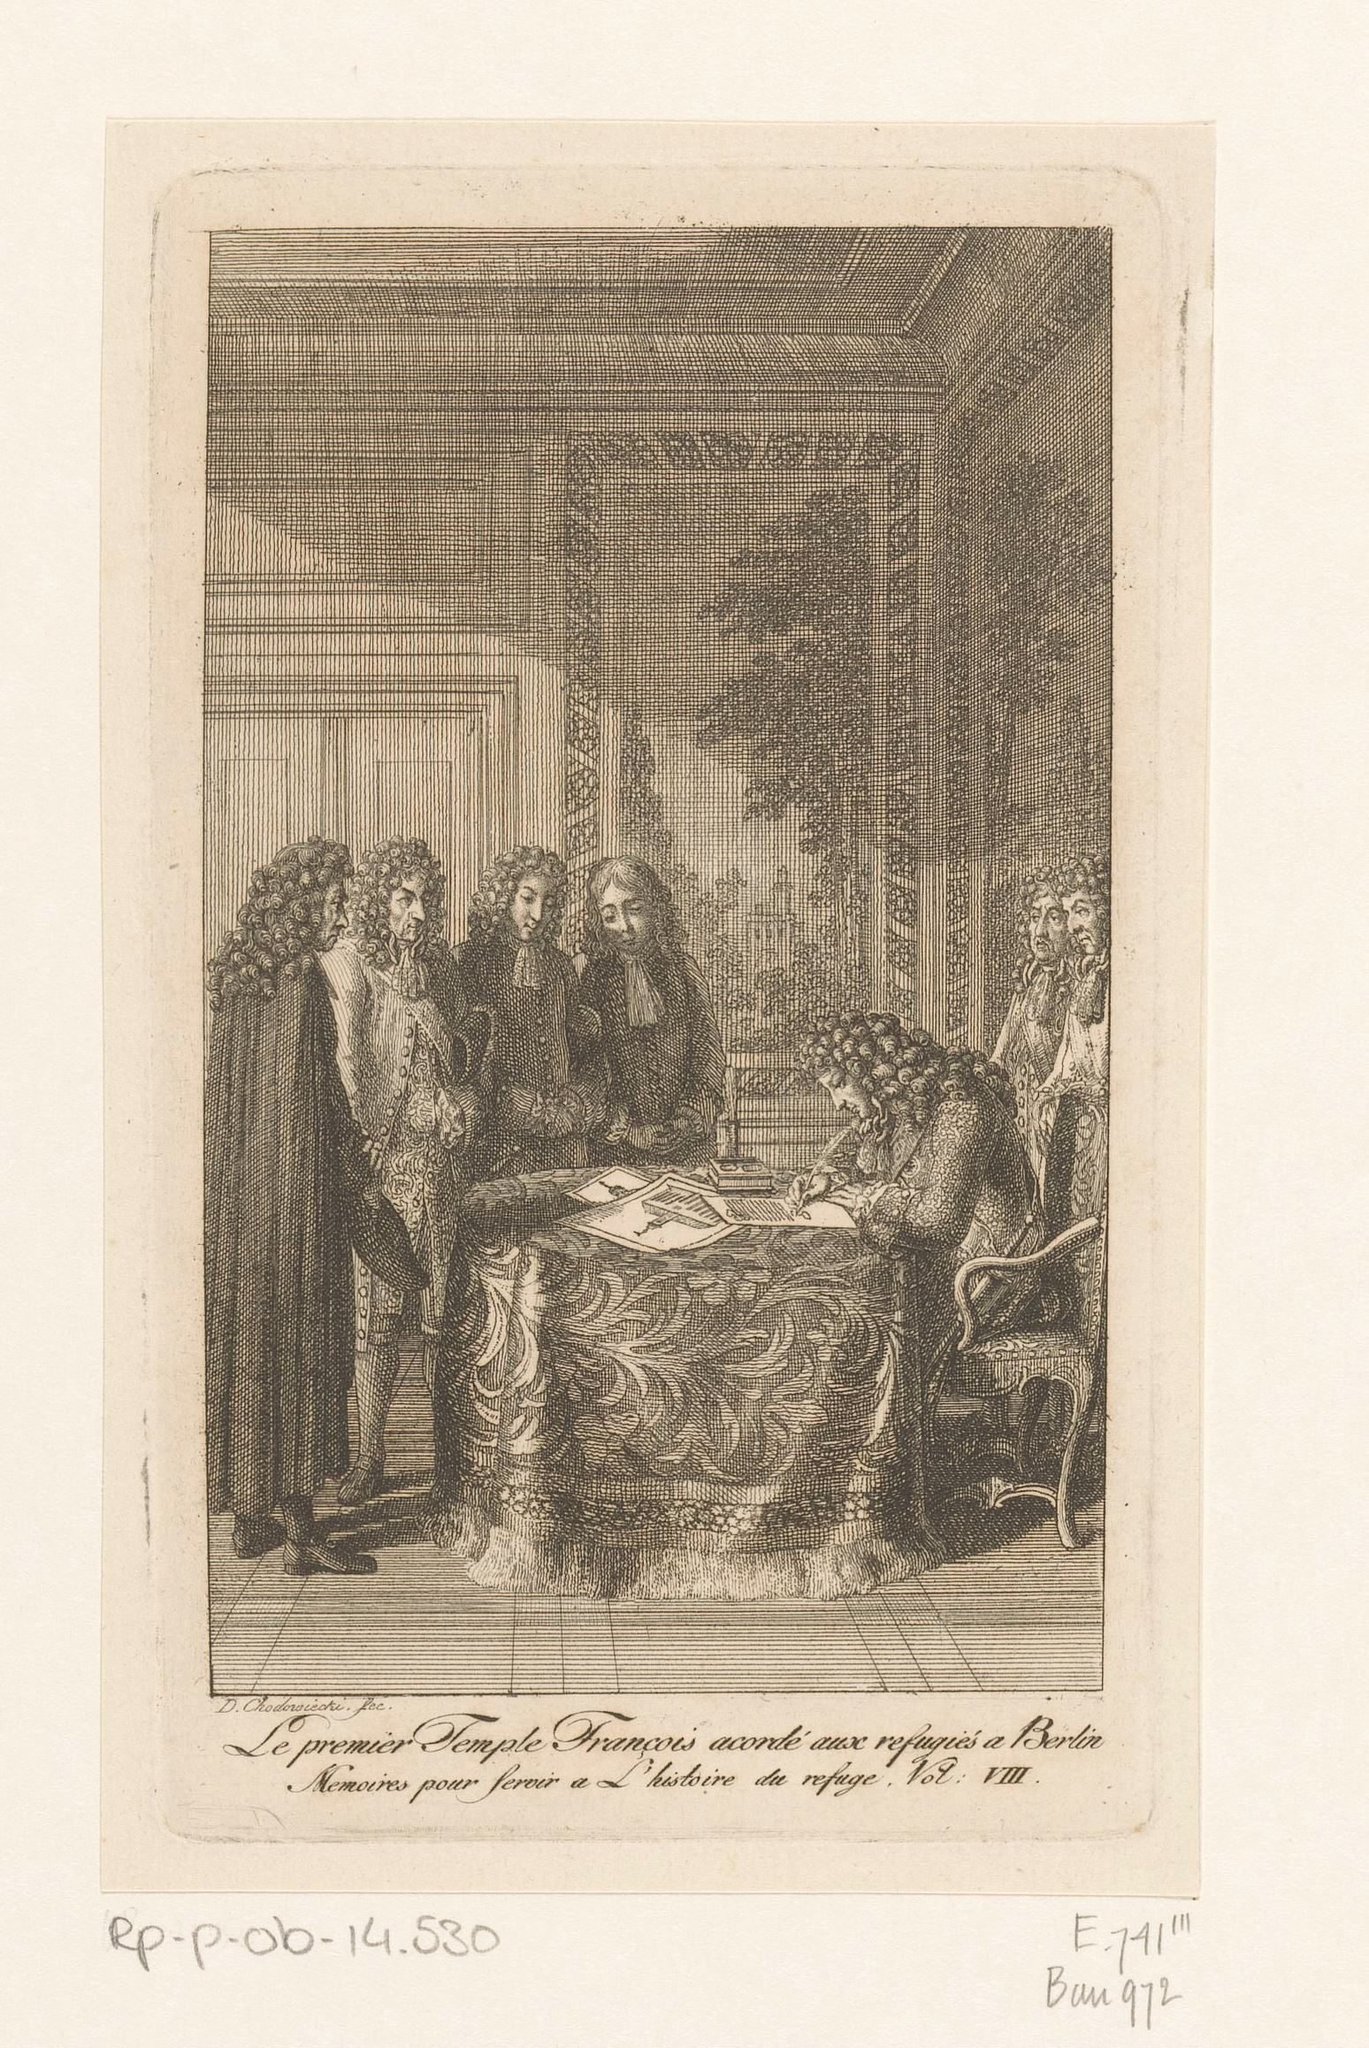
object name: book illustration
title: Friedrich I ondertekent het decreet voor de bouw van de kerk in Friedrichstadt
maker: daniel nikolaus chodowiecki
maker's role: draughtsman, print maker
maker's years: 1726-1801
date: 1794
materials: paper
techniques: etching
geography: berlin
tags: friedrich i (koning van pruisen), interior of the house, building of church, ruler, sovereign, tapestry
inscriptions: collector's mark: Lugt 2228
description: Prent gebruikt voor: Erman, Jean Pierre. Mémoires pour servir à l'histoire des réfugiés françois dans les états du roi. 9 dln. Berlijn: Fred. Barbiez, 1794, dl. 8.